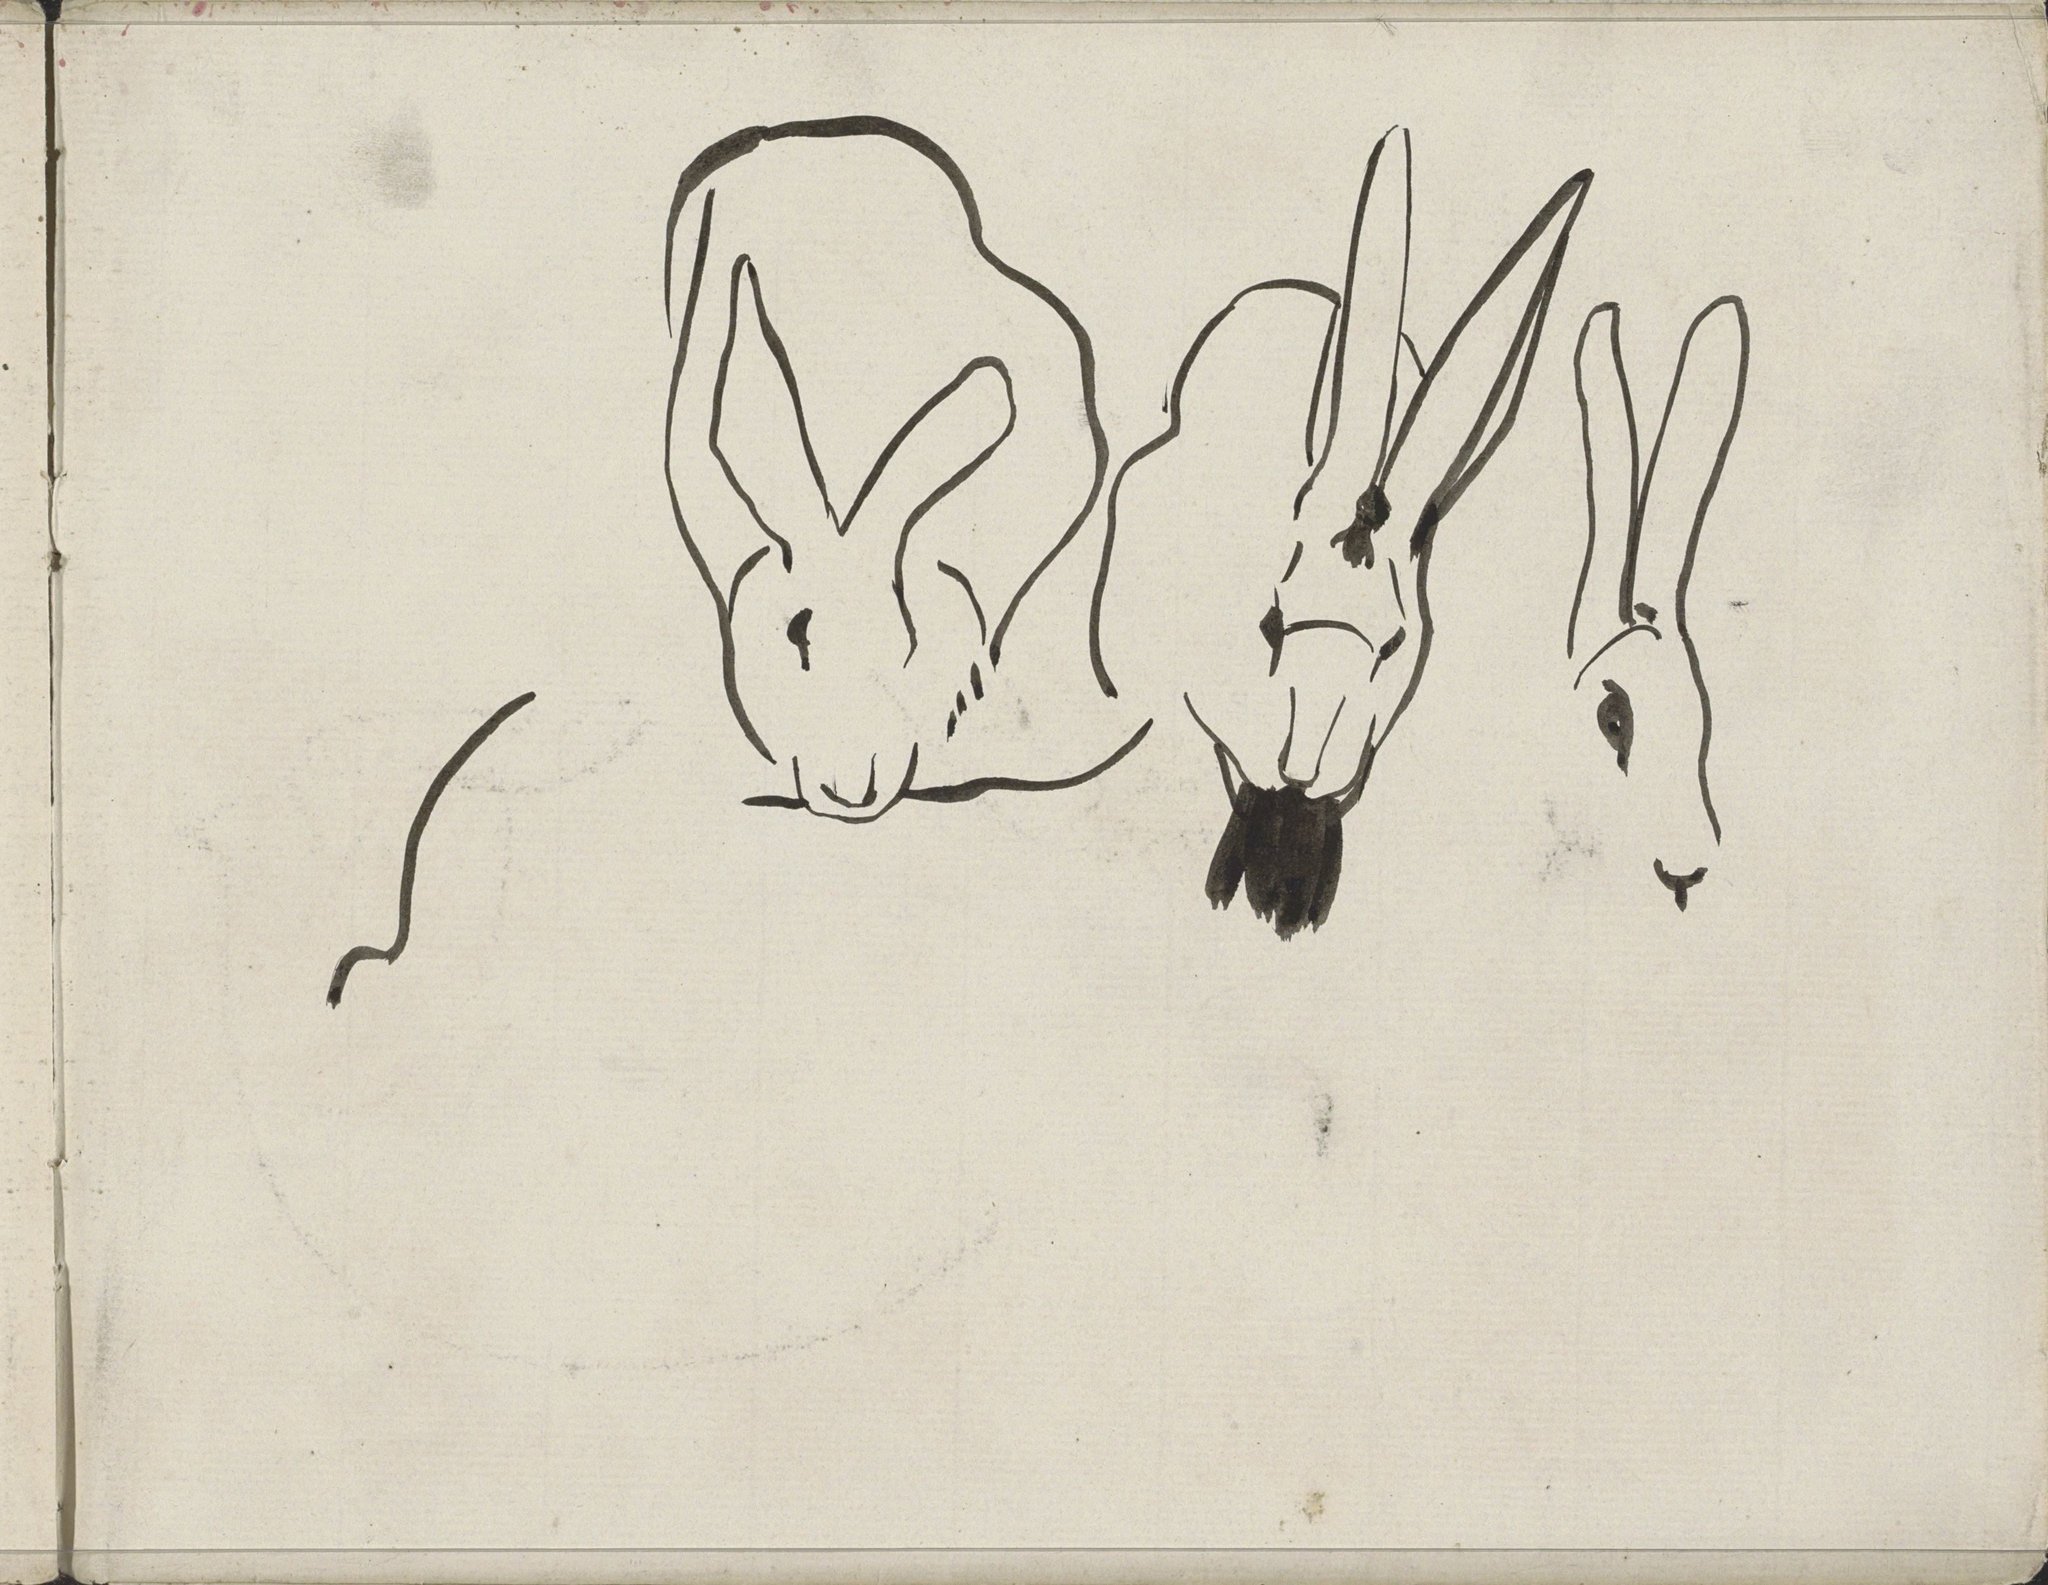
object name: sketchbook leaf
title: Konijnen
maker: carel adolph lion cachet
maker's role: draughtsman, print maker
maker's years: 1864-1945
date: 1896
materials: ink, paper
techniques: brush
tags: rodents: rabbit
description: Blad 43 recto uit een schetsboek met 44 bladen.